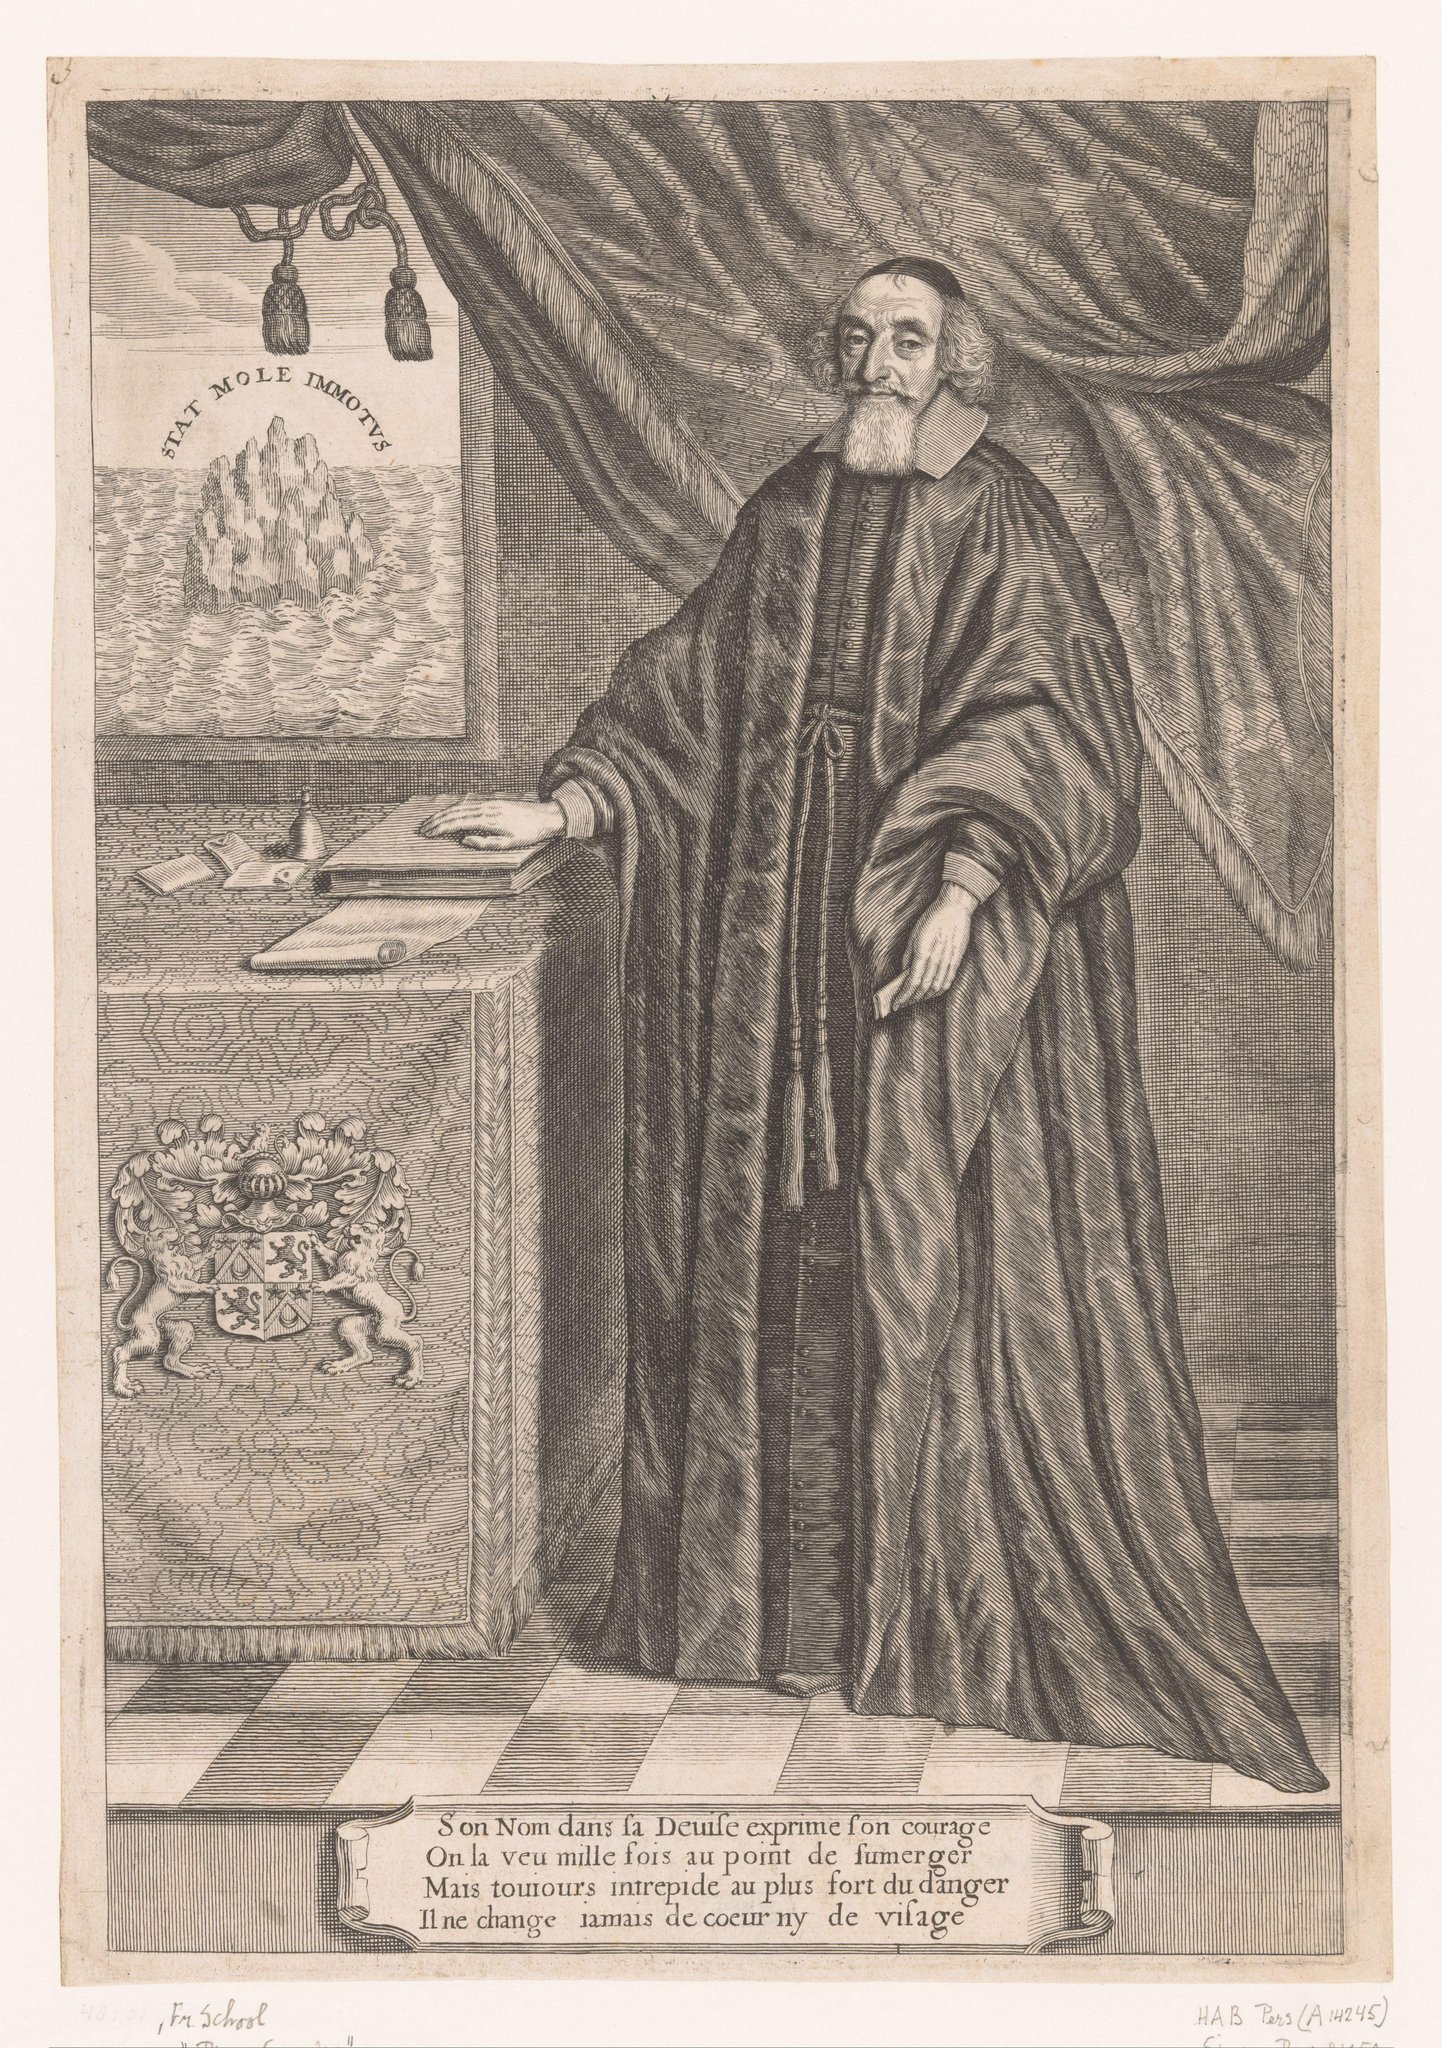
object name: print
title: Portret van Mathieu Molé of Pierre de Seguier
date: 1600-1667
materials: paper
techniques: engraving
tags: mathieu molé, paris, pierre séguier, historical persons, armorial bearing, heraldry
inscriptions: collector's mark: Lugt 2228, collector's mark: Lugt 151